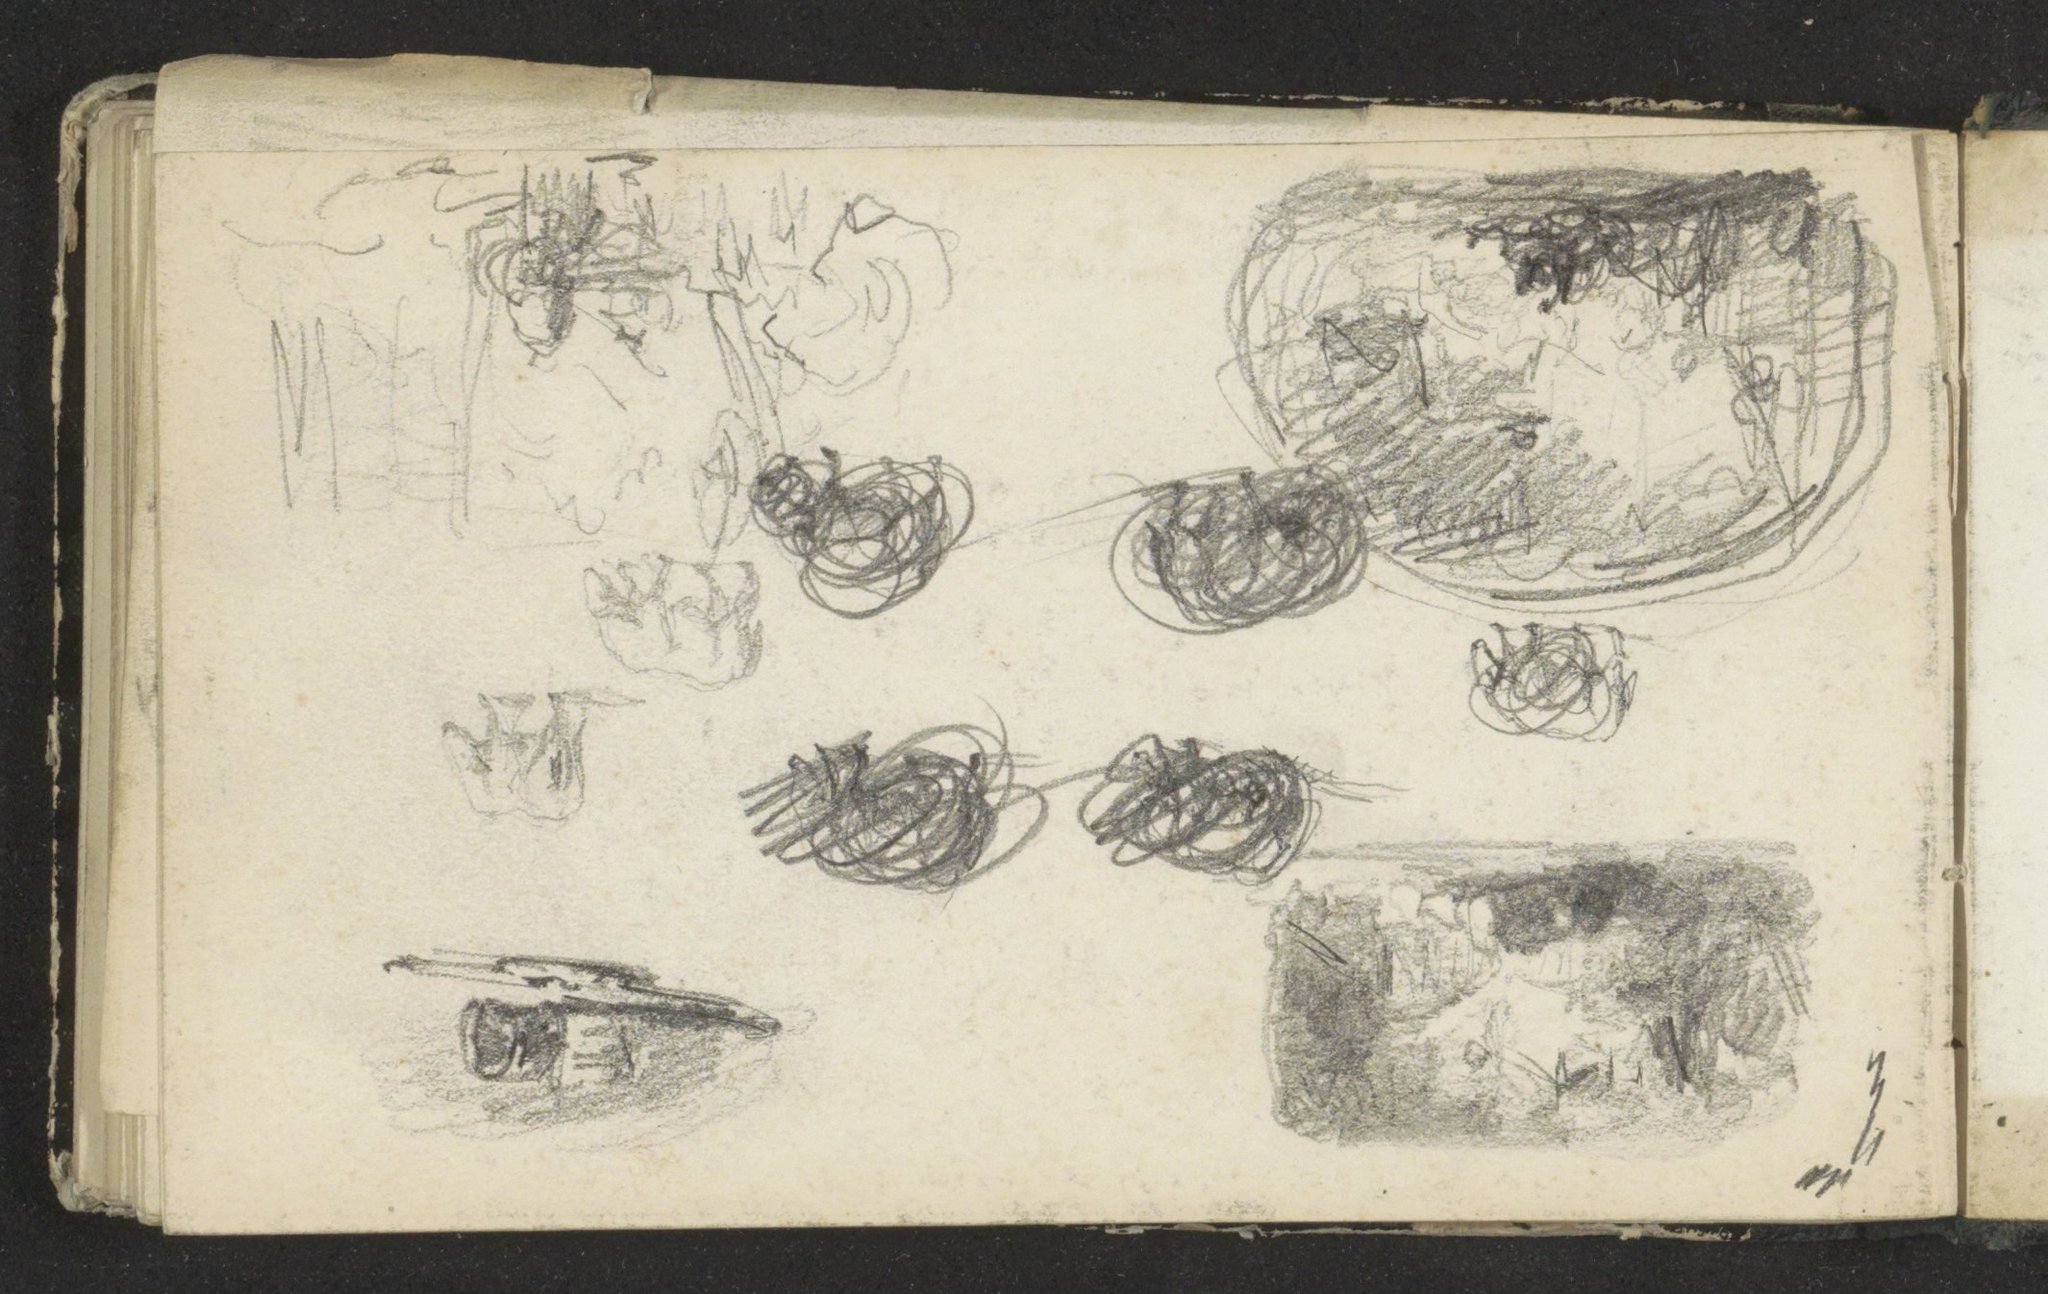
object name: sketchbook leaf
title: Studieblad, onder andere met landschappen en dieren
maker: maria vos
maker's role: draughtsman, painter, print maker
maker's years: 1824-1906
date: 1834-1906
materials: paper, pencil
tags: landscapes, animals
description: Blad 46 verso uit een schetsboek met 46 bladen.